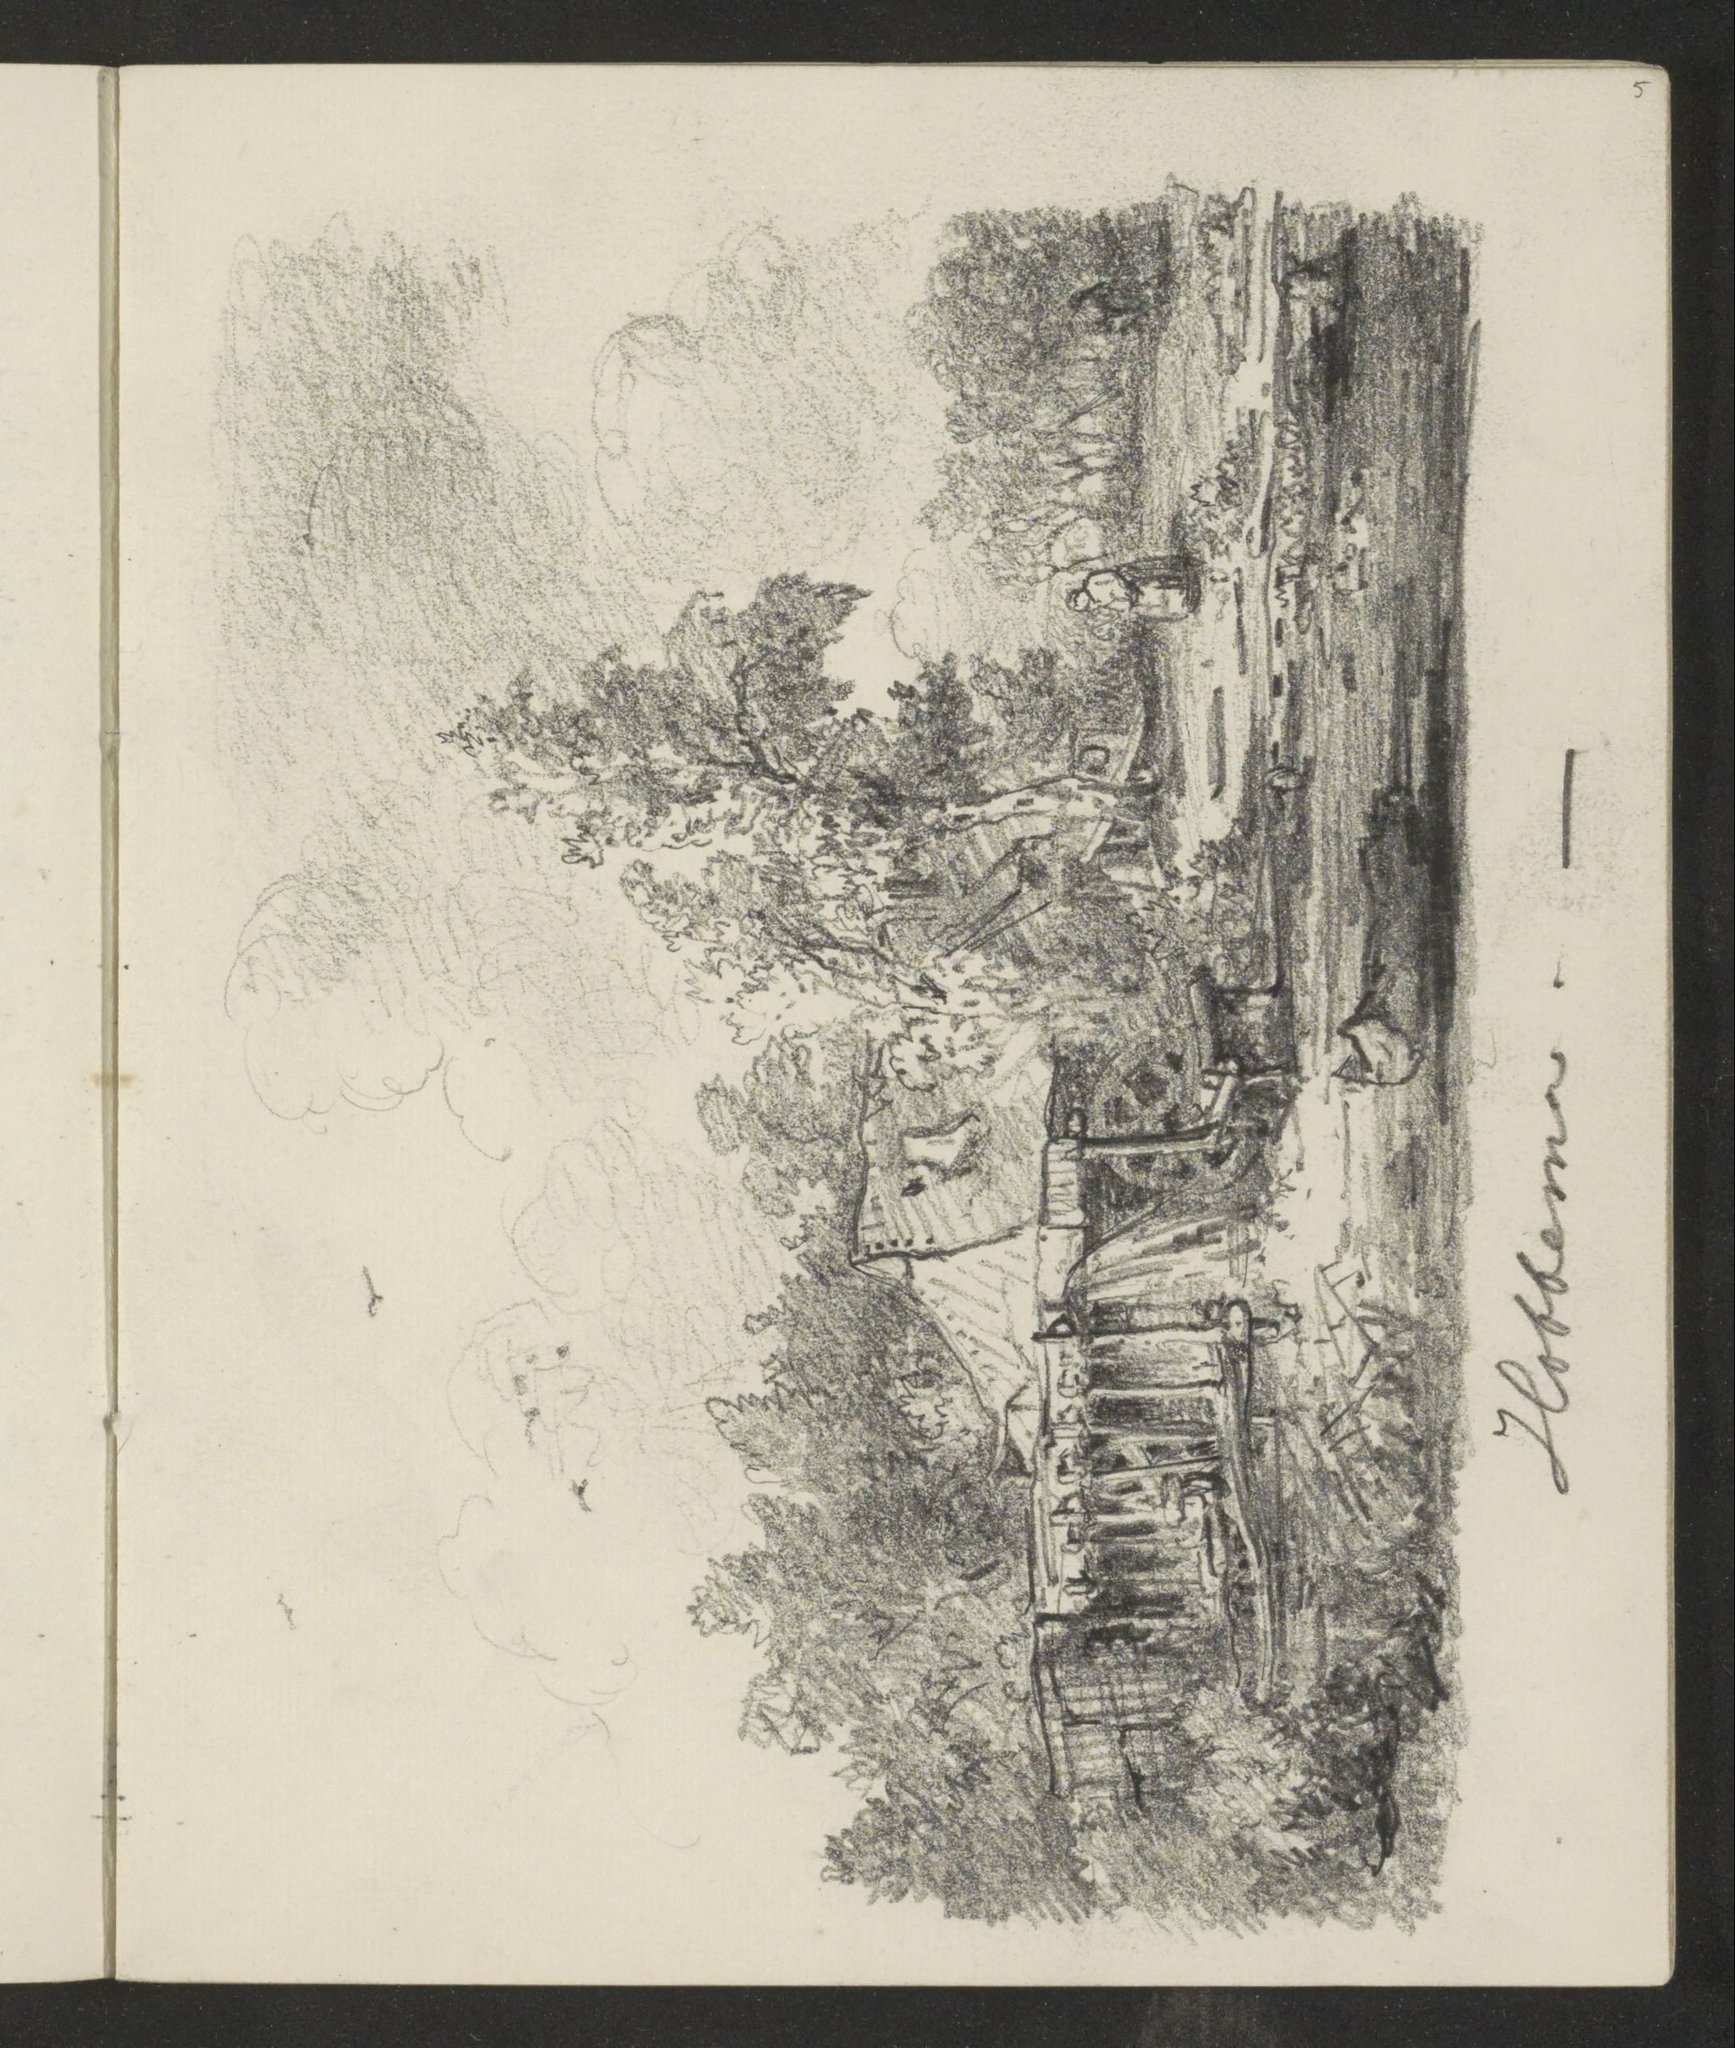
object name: sketchbook leaf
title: Kopie naar Meindert Hobbema's 'Een watermolen'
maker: maria vos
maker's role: draughtsman, painter, print maker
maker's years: 1824-1906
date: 1858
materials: paper, pencil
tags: watermill in landscape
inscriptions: annotation: ‘Hobbema.-’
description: Blad 5 recto uit een schetsboek met 19 bladen.